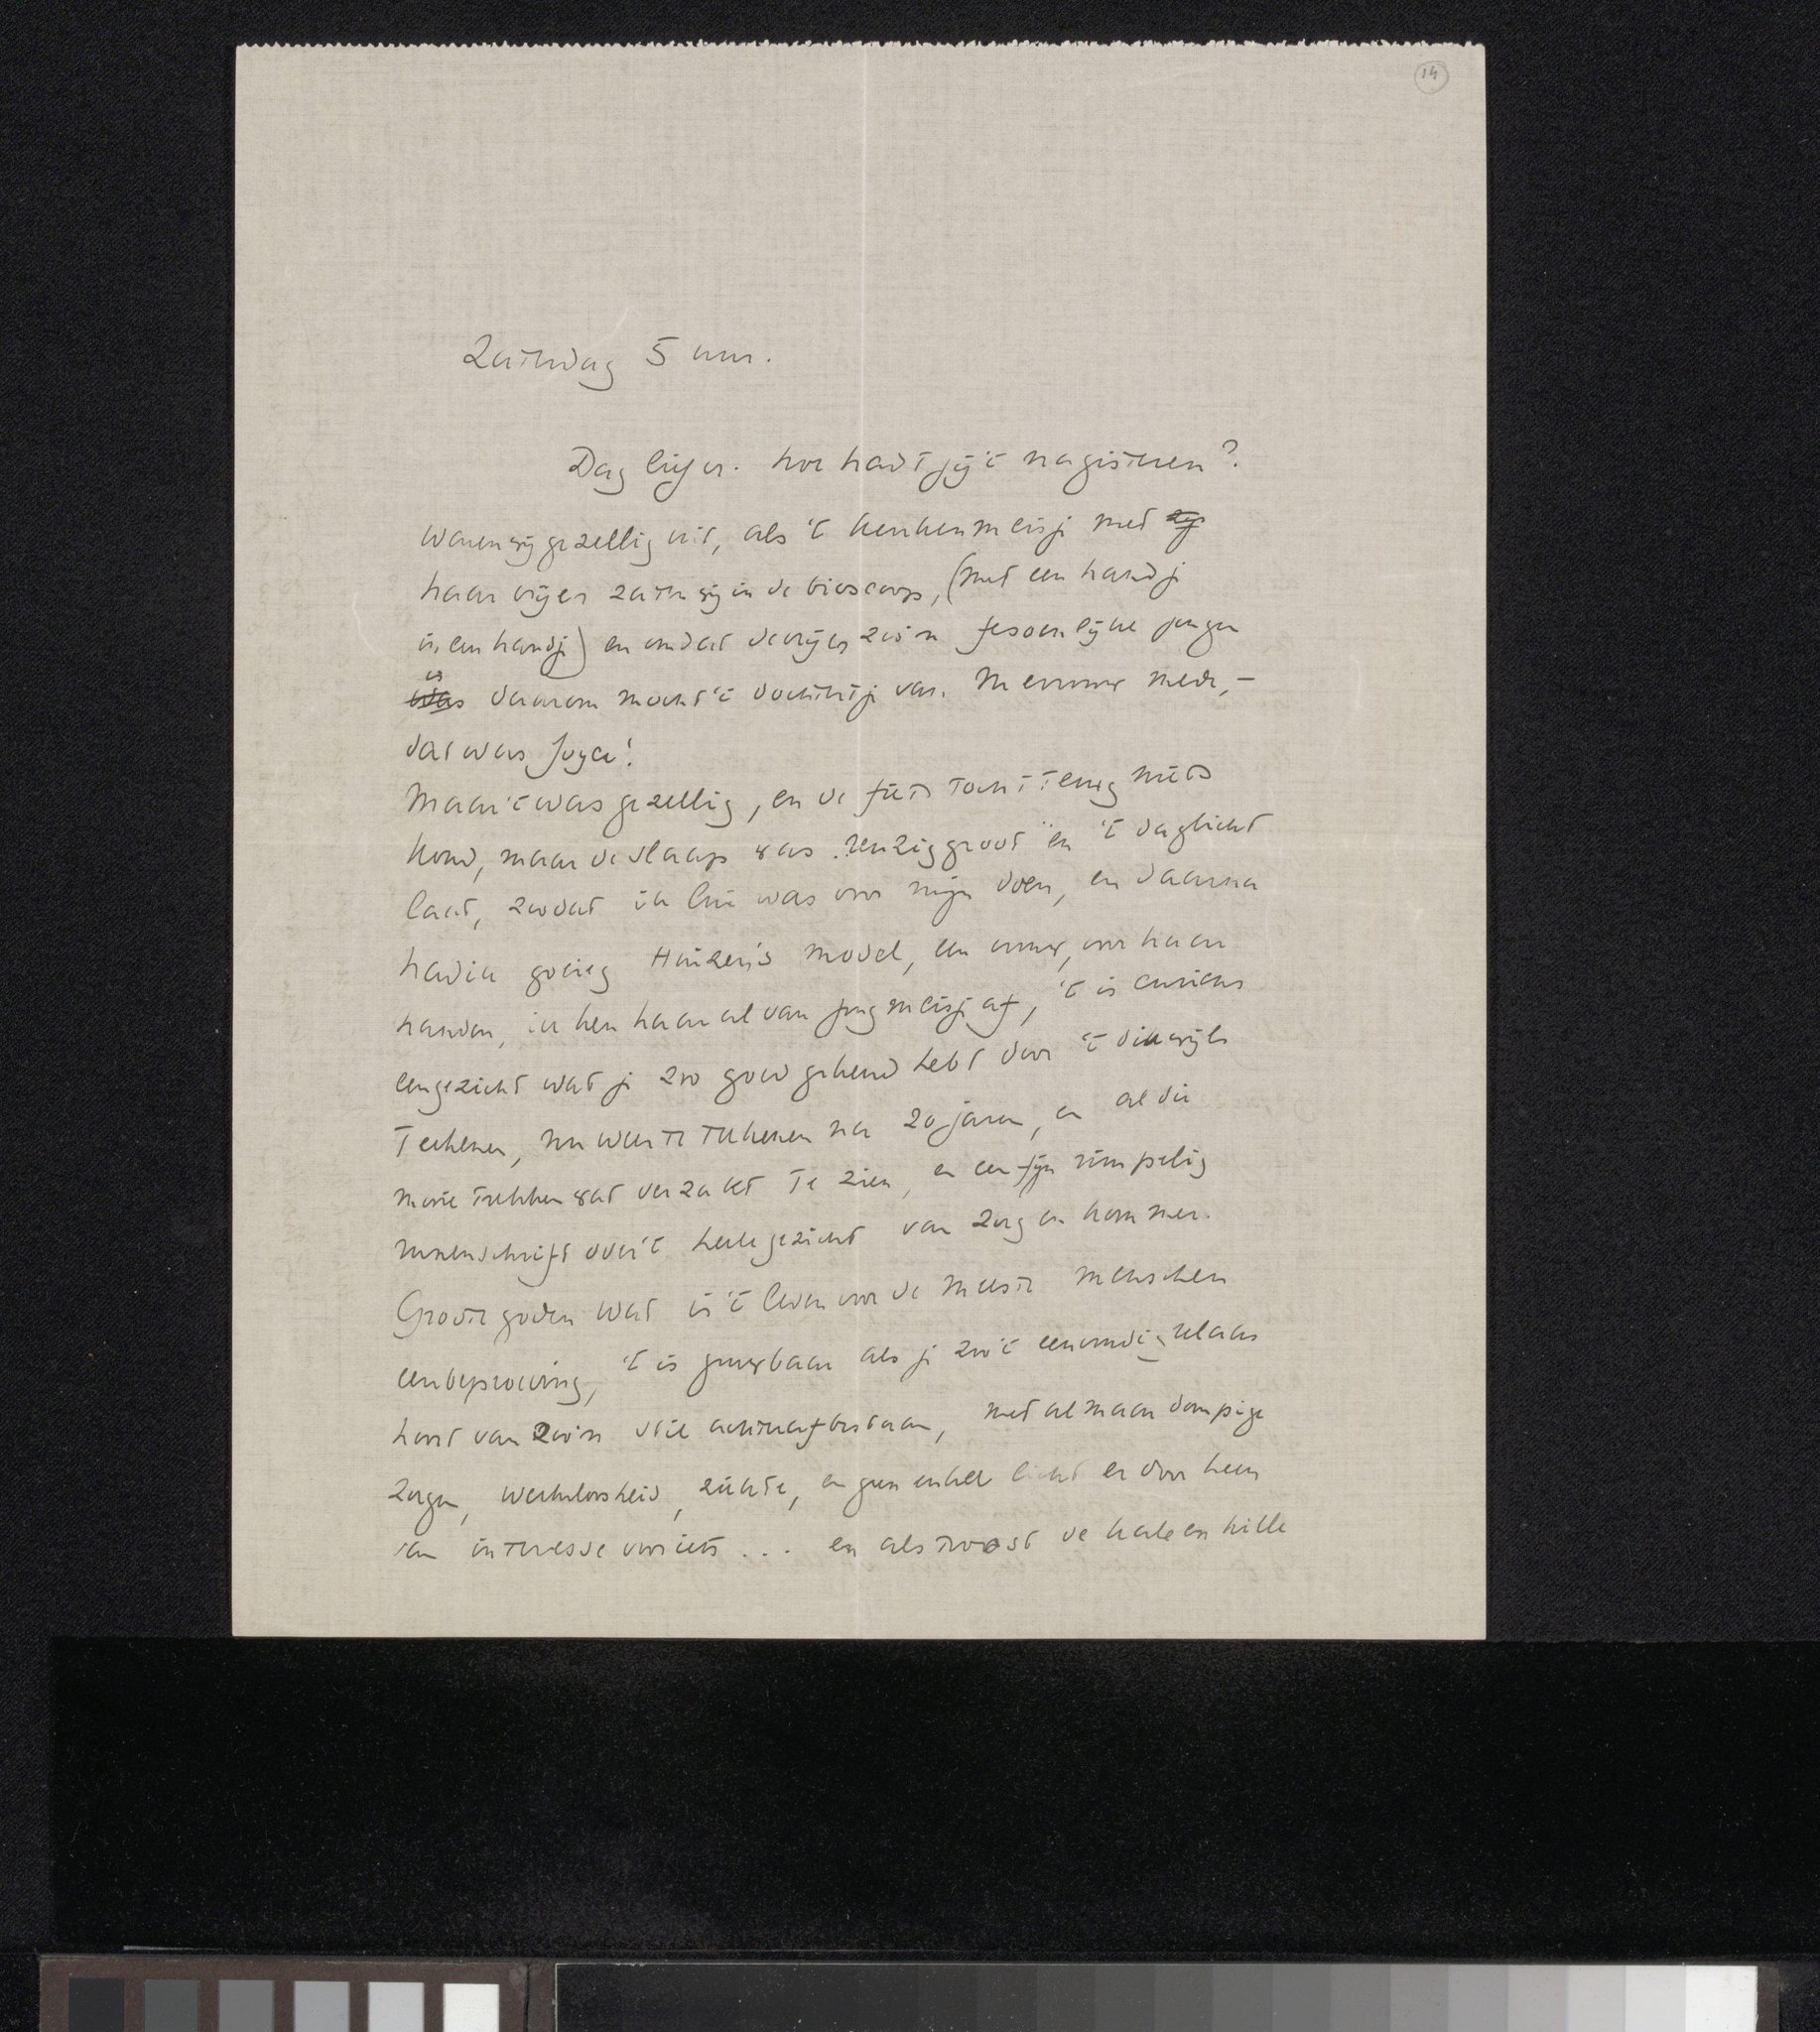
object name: letter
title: Brief aan Ina van Eibergen Santhagens-Waller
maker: richard nicolaüs roland holst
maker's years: 1868-1938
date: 1878-1938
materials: ink, paper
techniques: pen, writing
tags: haarlem, amsterdam, print maker, ina van eibergen santhagens-waller, passions, emotions, affections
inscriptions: collector's mark: ‘RPK’